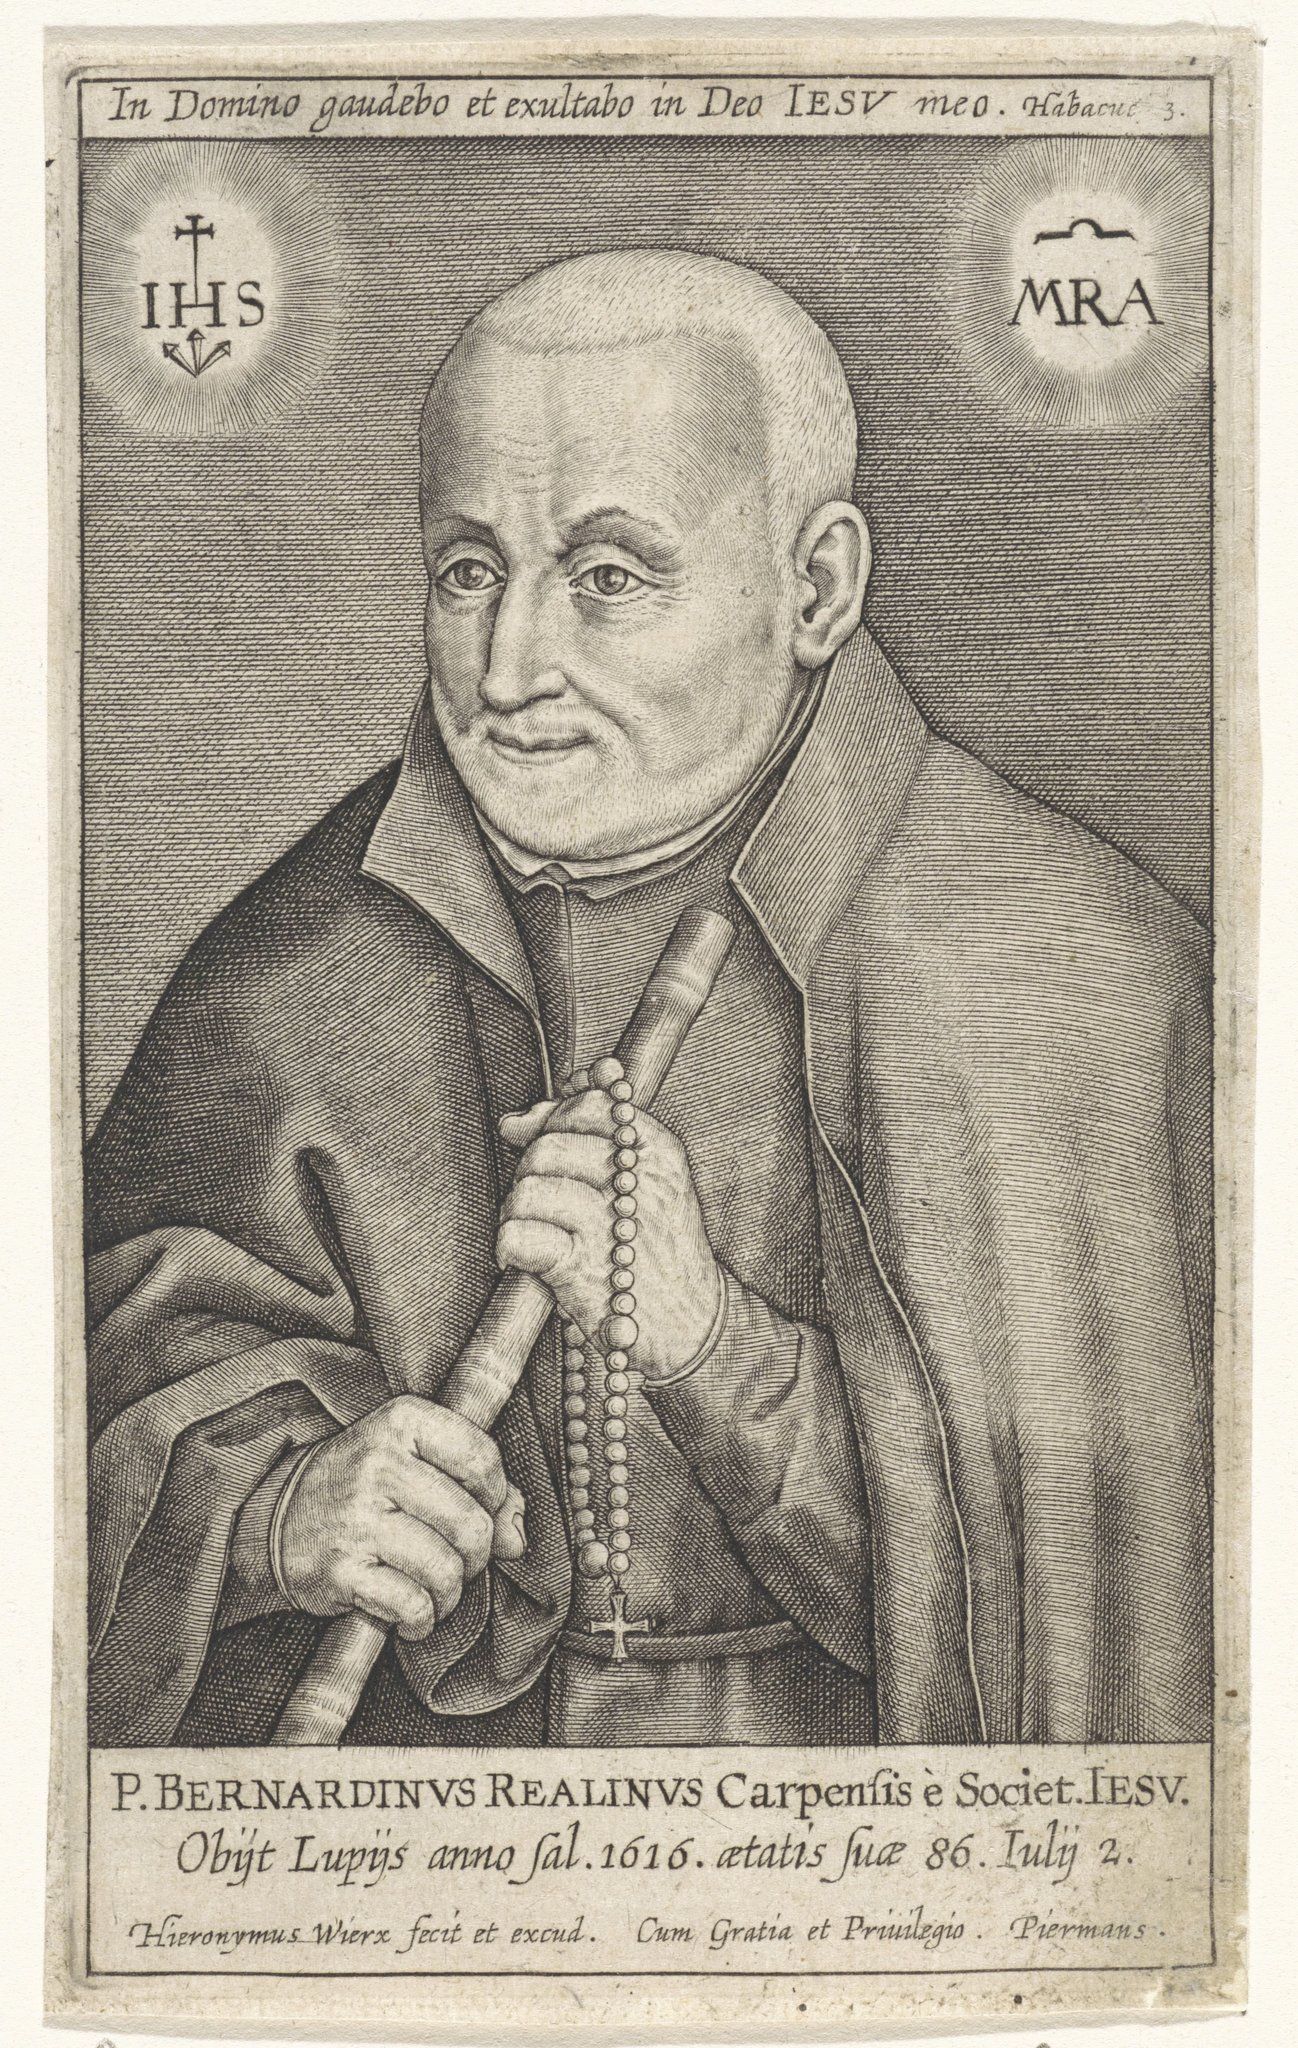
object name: print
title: Portret van de jezuïet Bernardin Realini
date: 1616-1619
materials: paper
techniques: engraving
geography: antwerp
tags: ihs ('iesus hominum salvator') ~ symbol of christ, aids for prayer, e.g. rosary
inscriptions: collector's mark: Lugt 2228, collector's mark: Lugt 1337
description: Hij heeft een rozenkrans en een stok in zijn handen. Linksboven het embleem van de jezuïeten, rechtsboven een monogram met de letters "MRA". De prent heeft een bovenschrift in het Latijn. In de marge biografische gegevens van de geportretteerde in het Latijn.